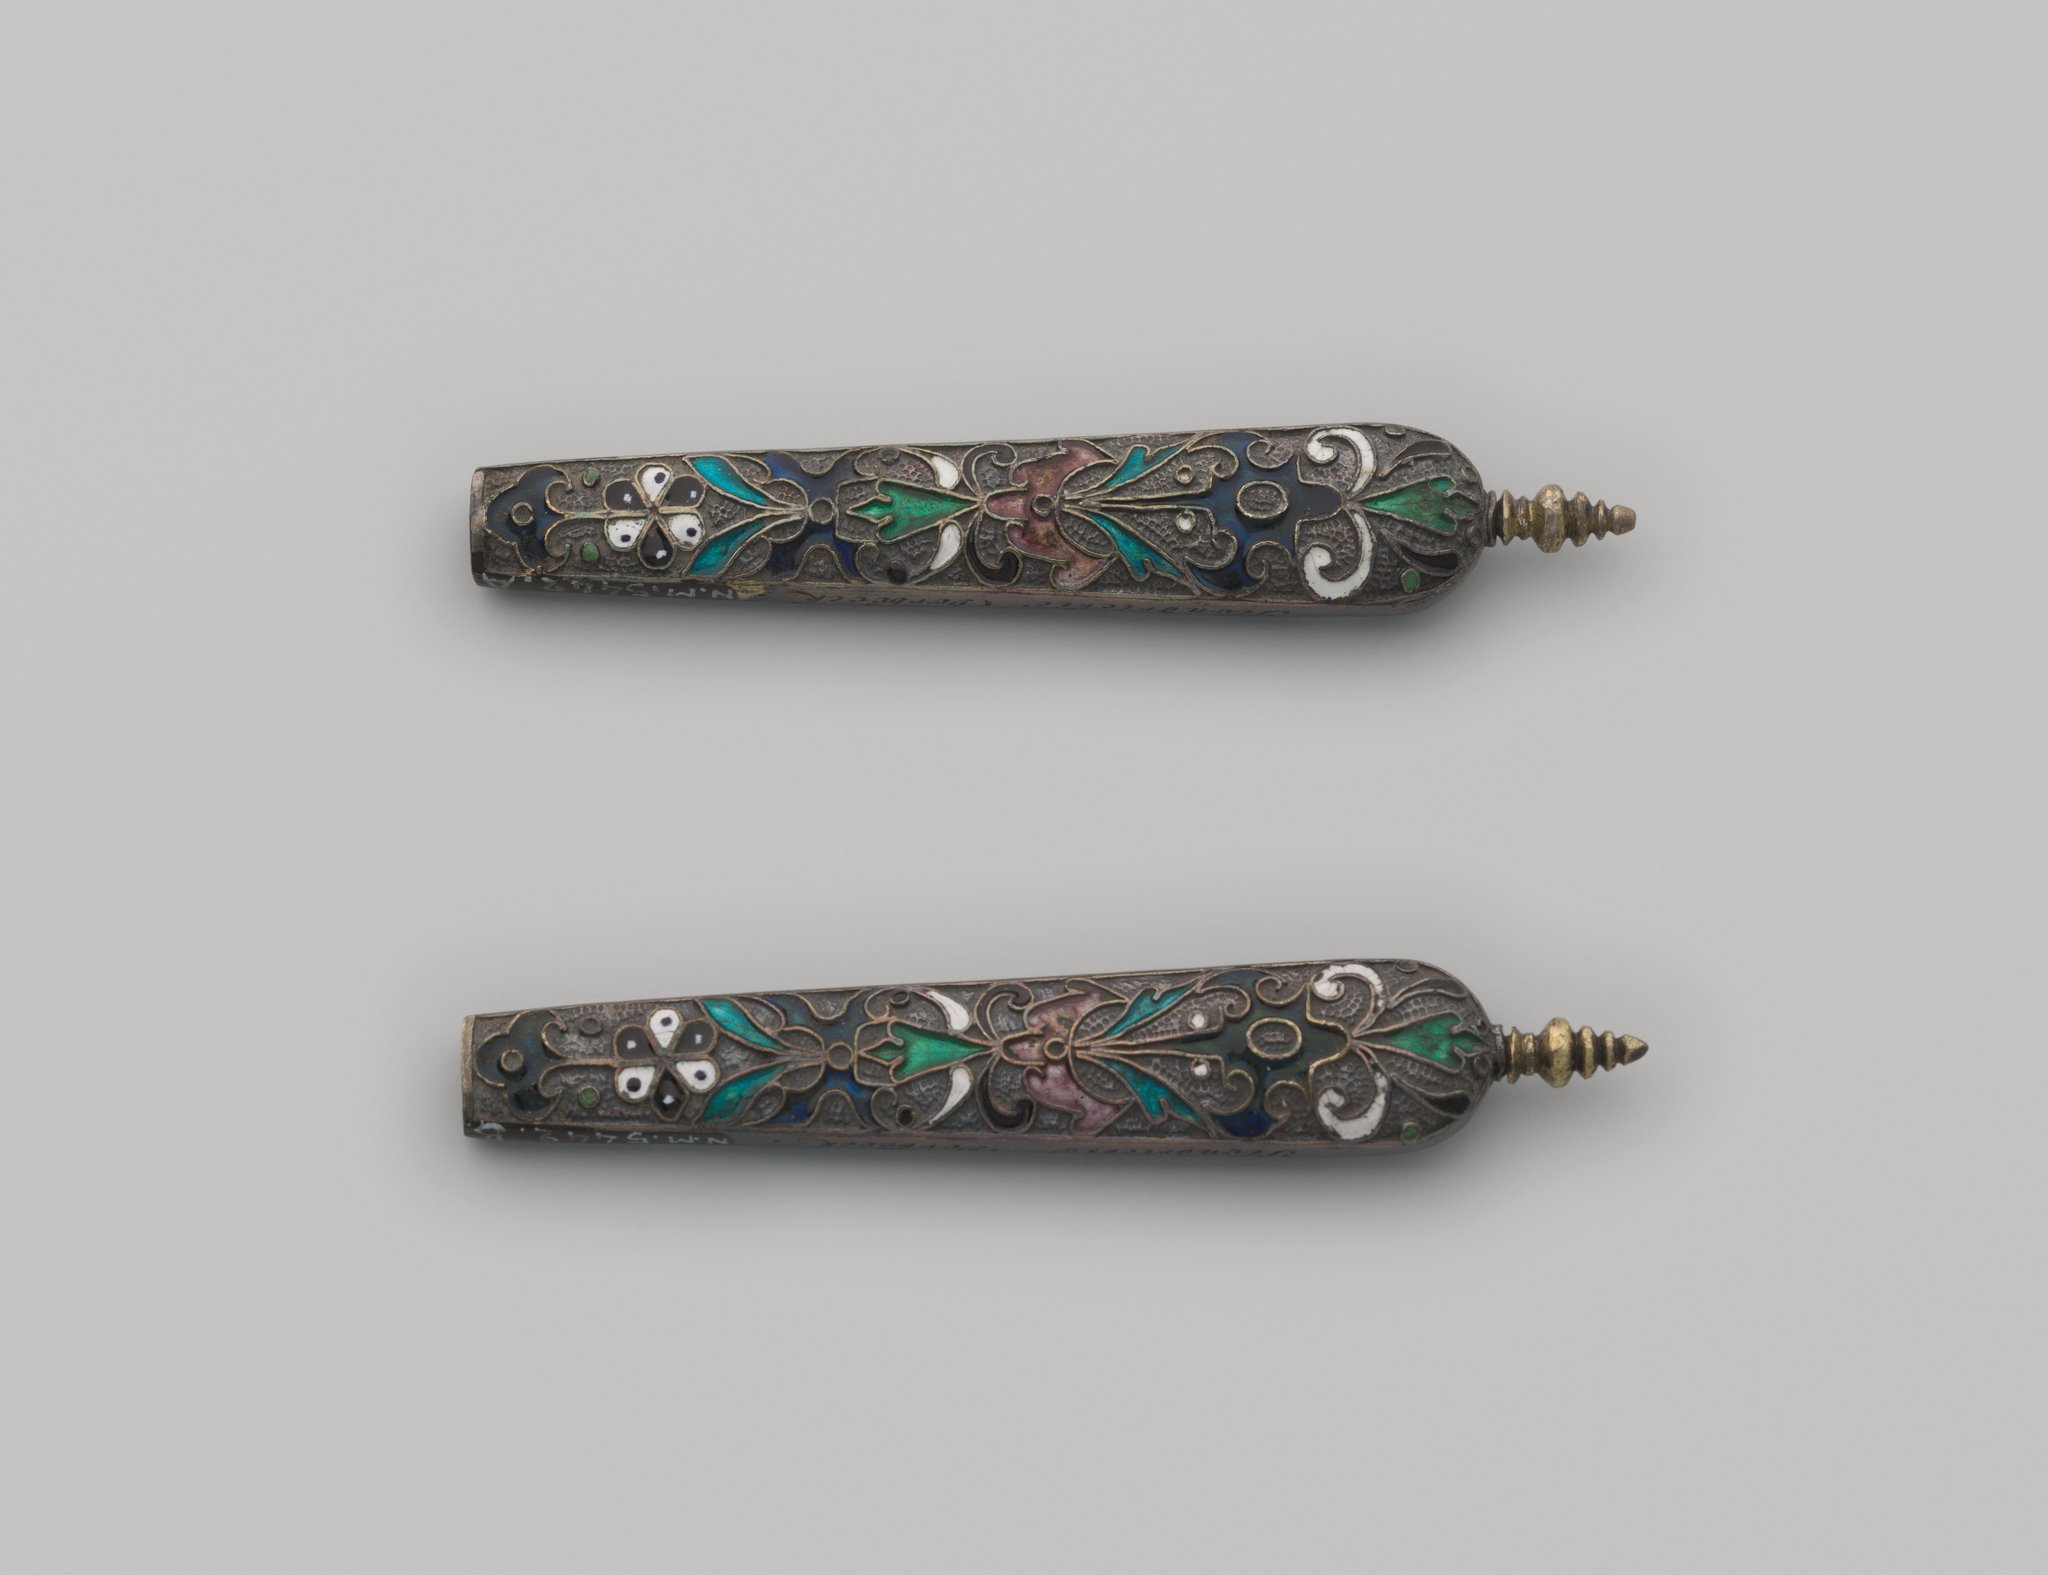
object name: haft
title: Heft van verguld zilver met bekroning van ronde knop. Versierin in email-cloisonné. Op zijkant gegraveerd: Endrickie Verbeeck/Rein van harten ; traech in tooren.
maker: Anonymous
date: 1600-1625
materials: silver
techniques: gilding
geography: northern netherlands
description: Heft van verguld zilver. Het uiteinde wordt bekroond met een rond knopje. De 2 zijden zijn versierd met motieven in cloisonné émail. Op de zijkant gegraveerd: Hendrickie Verbeeck / Rein van harten : traech in tooren.